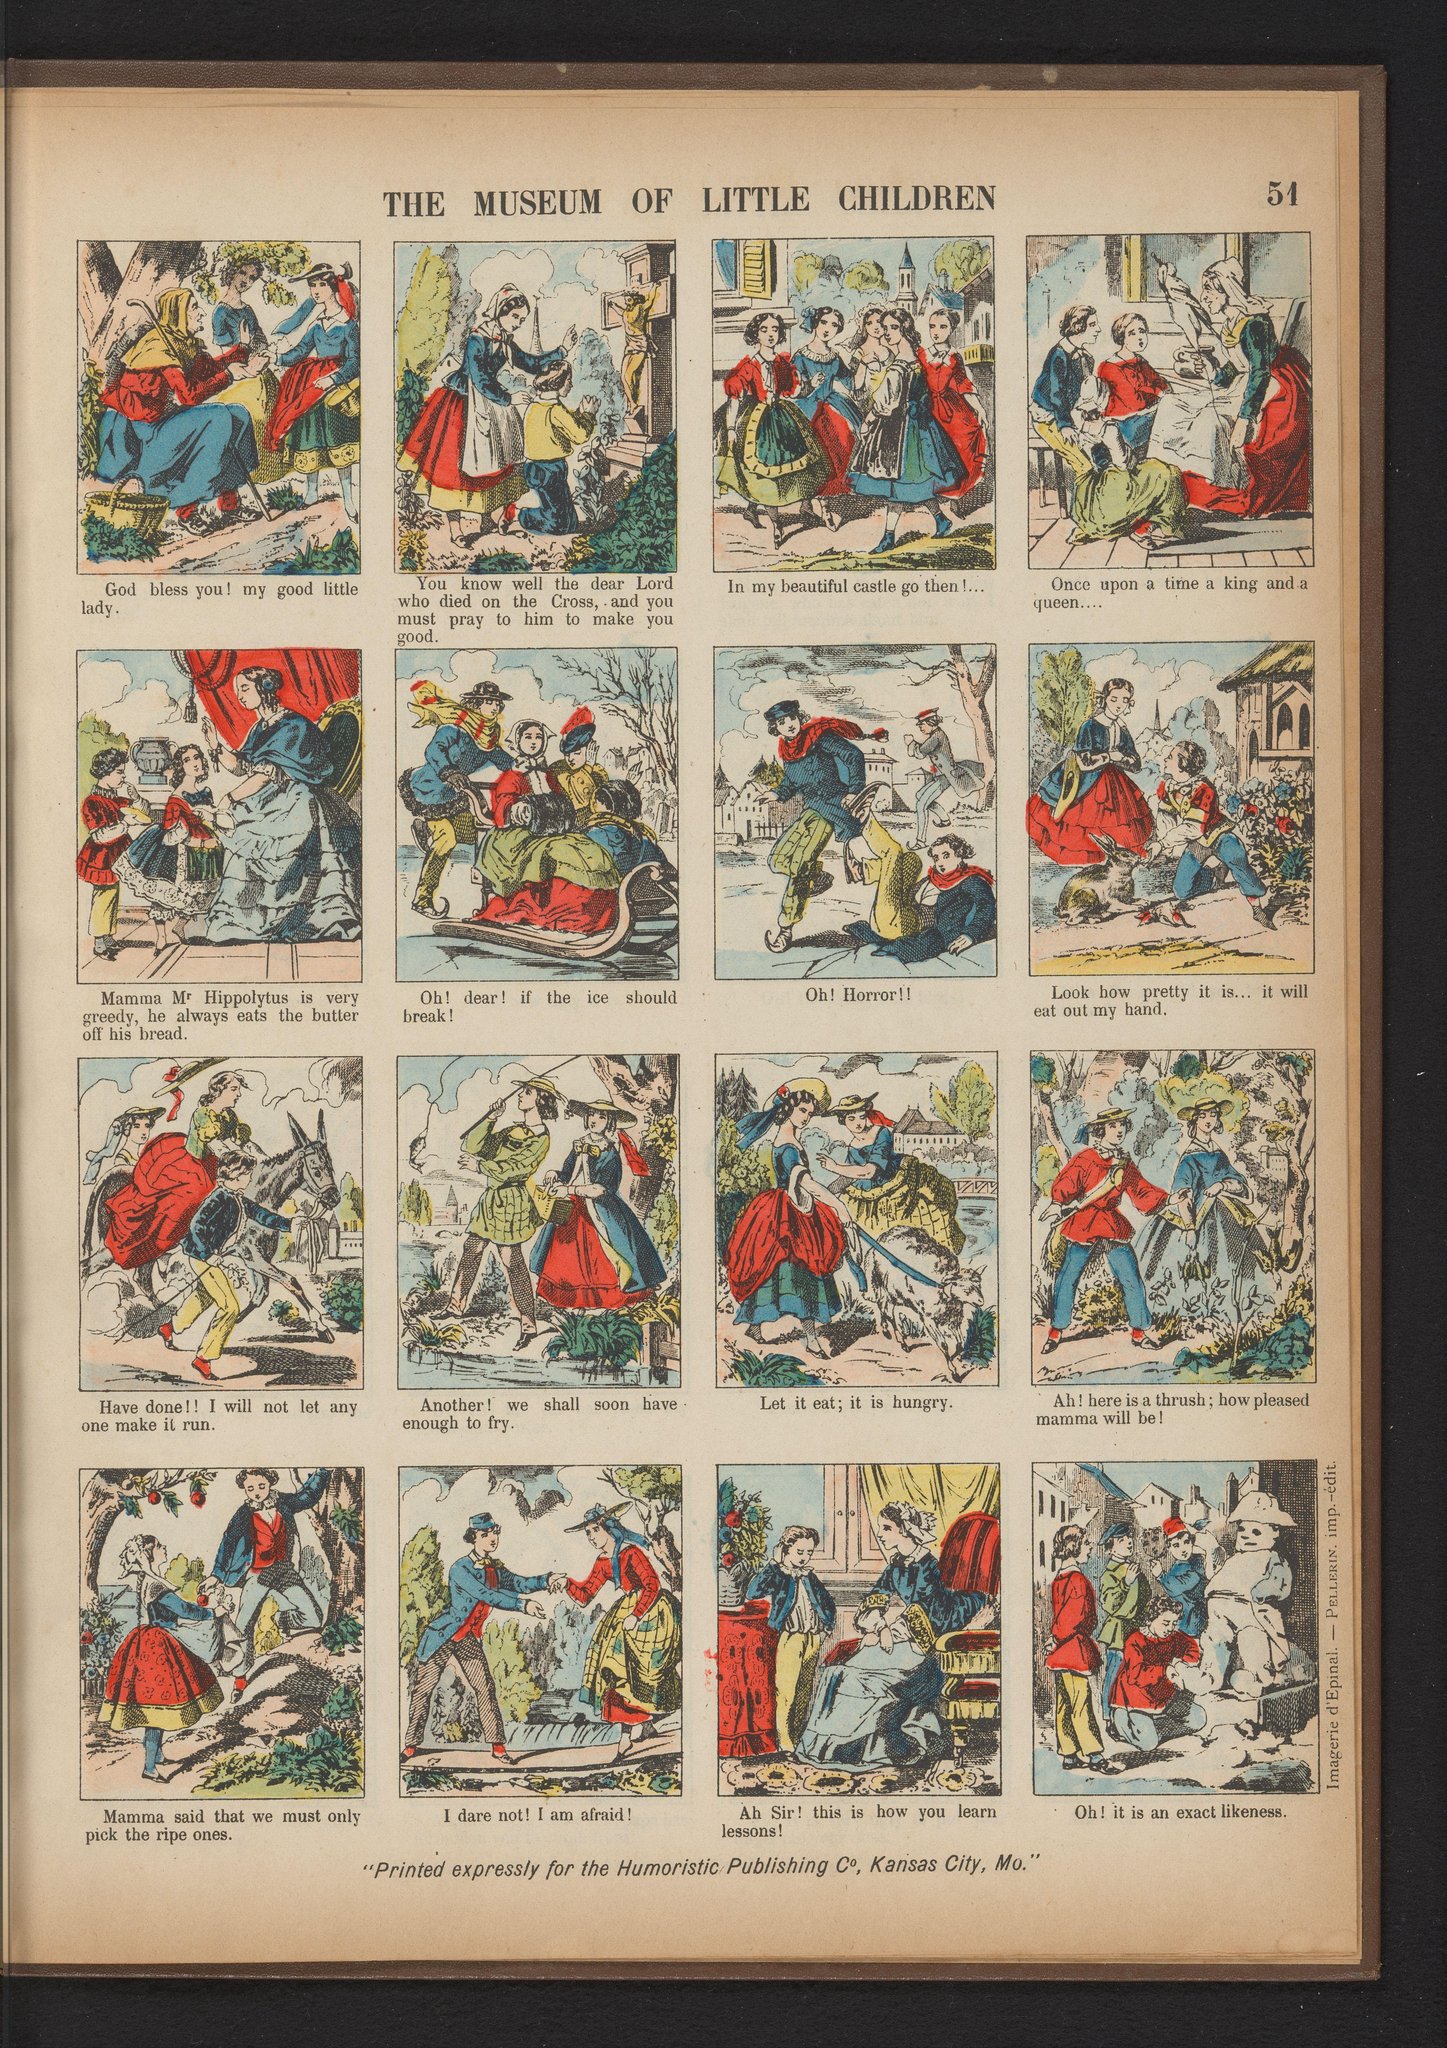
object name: popular print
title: The museum of little children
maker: Anonymous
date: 1893-1894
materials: paper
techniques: colour, letterpress printing, lithograph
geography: kansas city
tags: education, child between toddler and youth (of undetermined sex)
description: Blad met zestien voorstellingen van kinderen in diverse situaties. Onder elke voorstelling een onderschrift in het Engels. Deze prent maakt deel uit van een album.